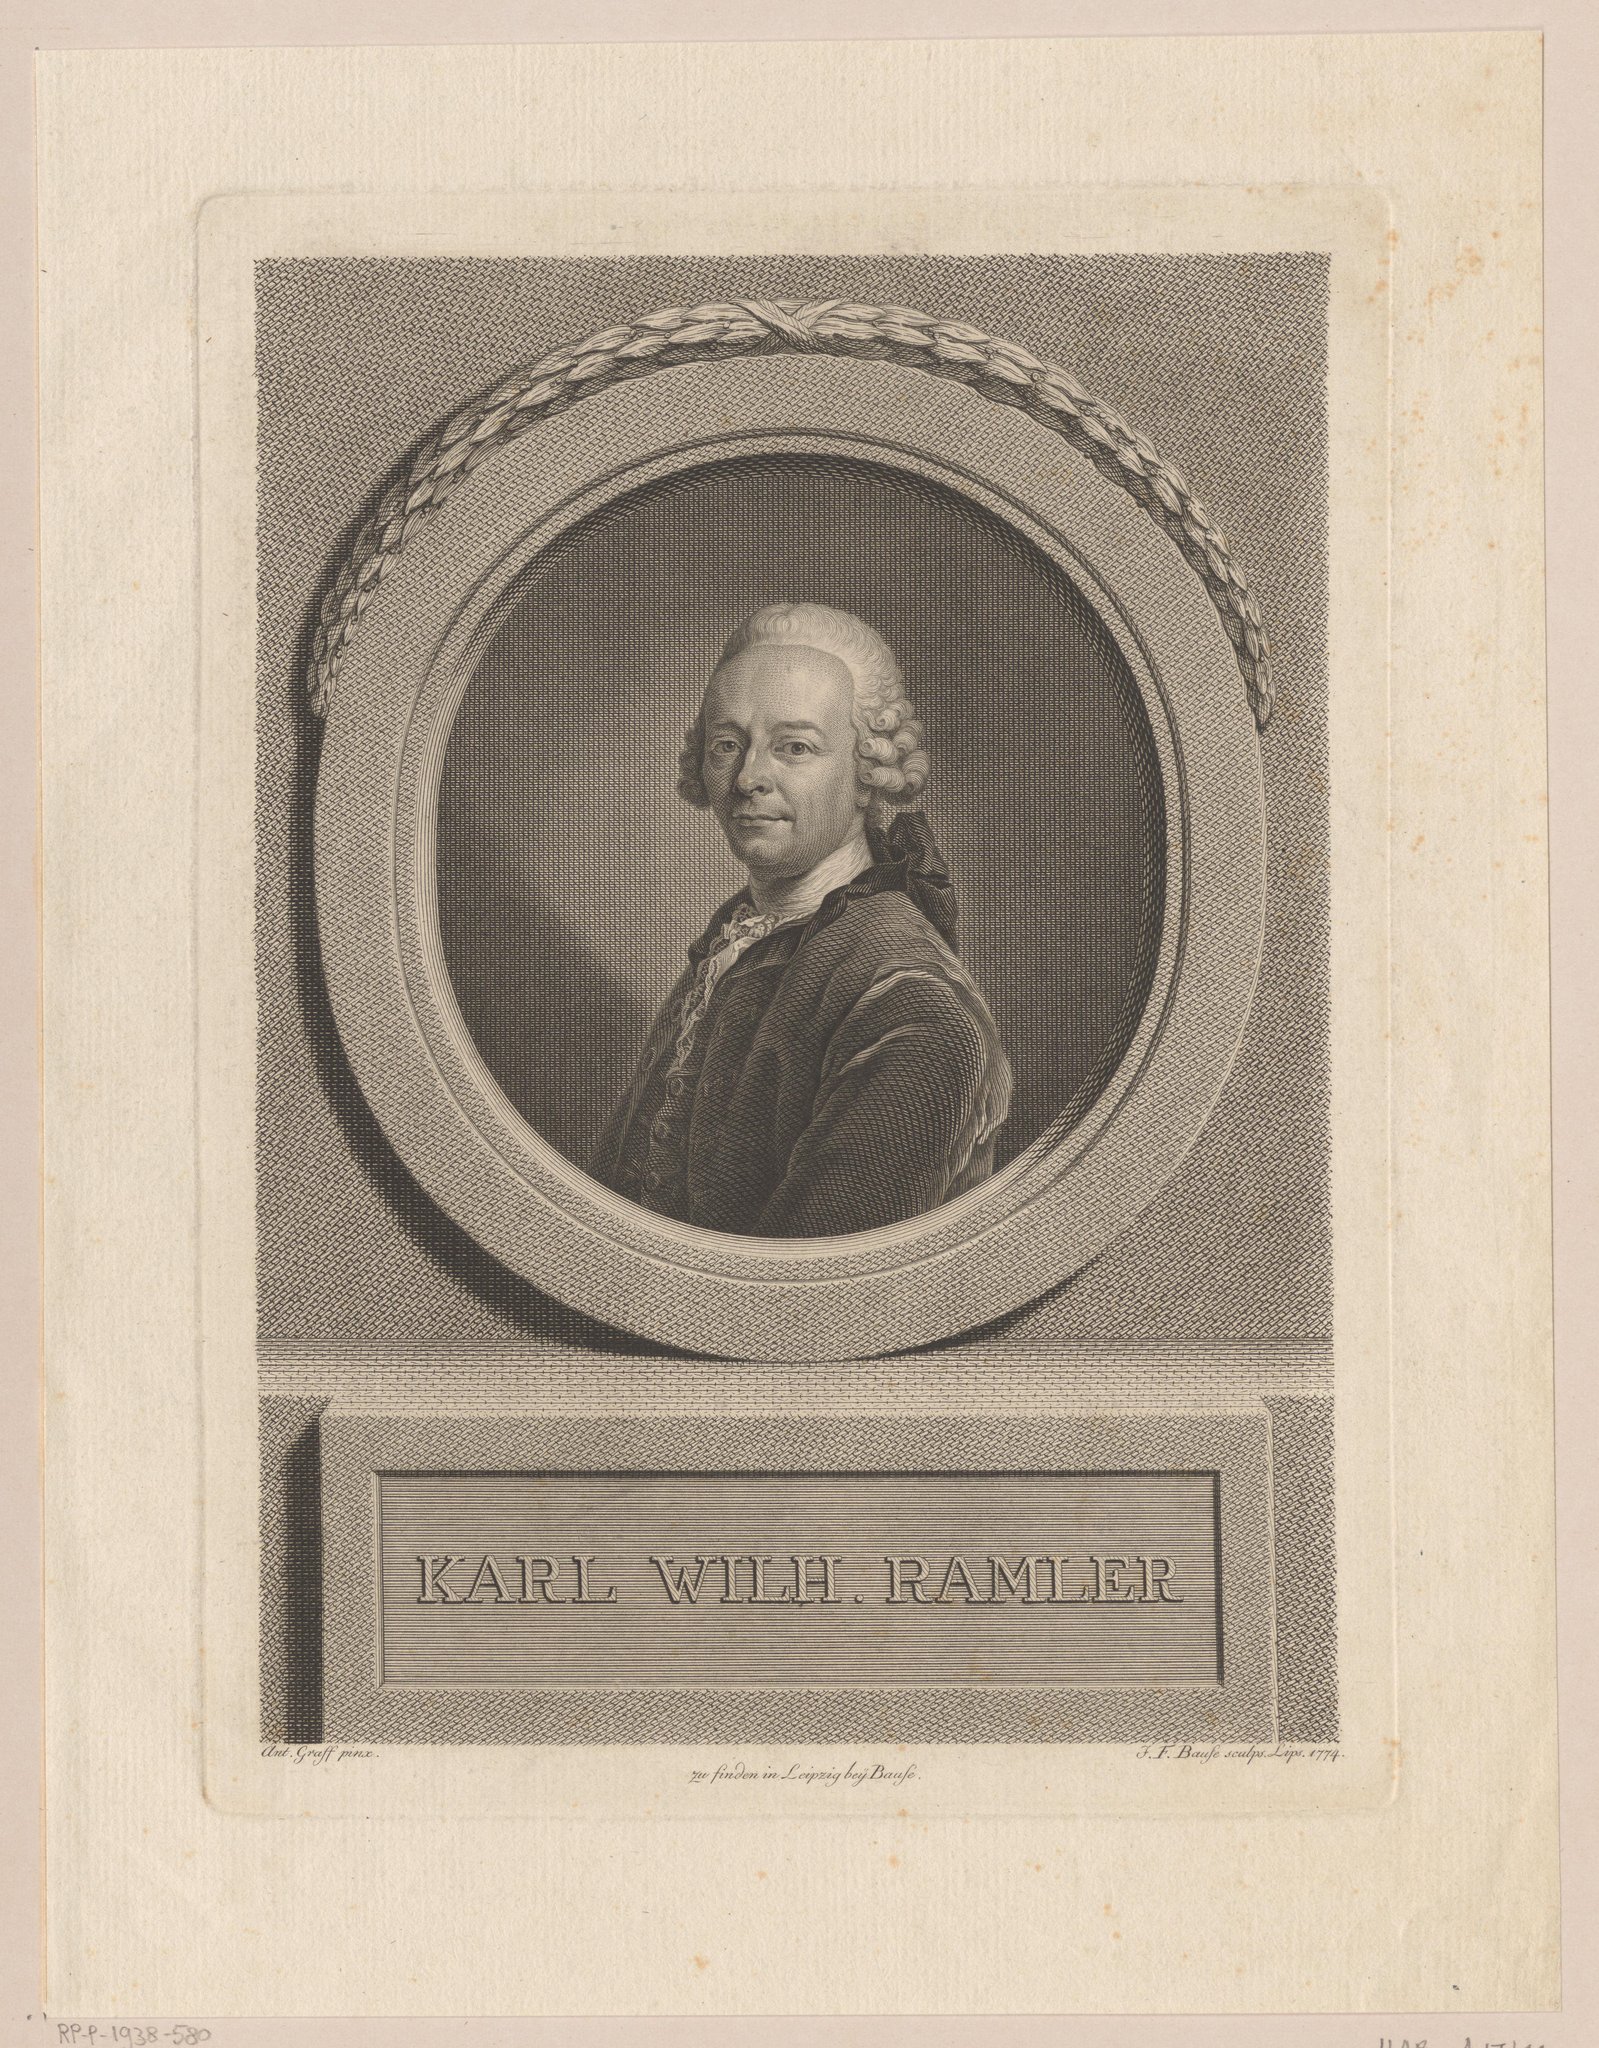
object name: print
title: Portret van Karl Wilhelm Ramler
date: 1774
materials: paper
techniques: engraving, etching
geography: leipzig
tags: berlin, historical persons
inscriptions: collector's mark: Lugt 2228